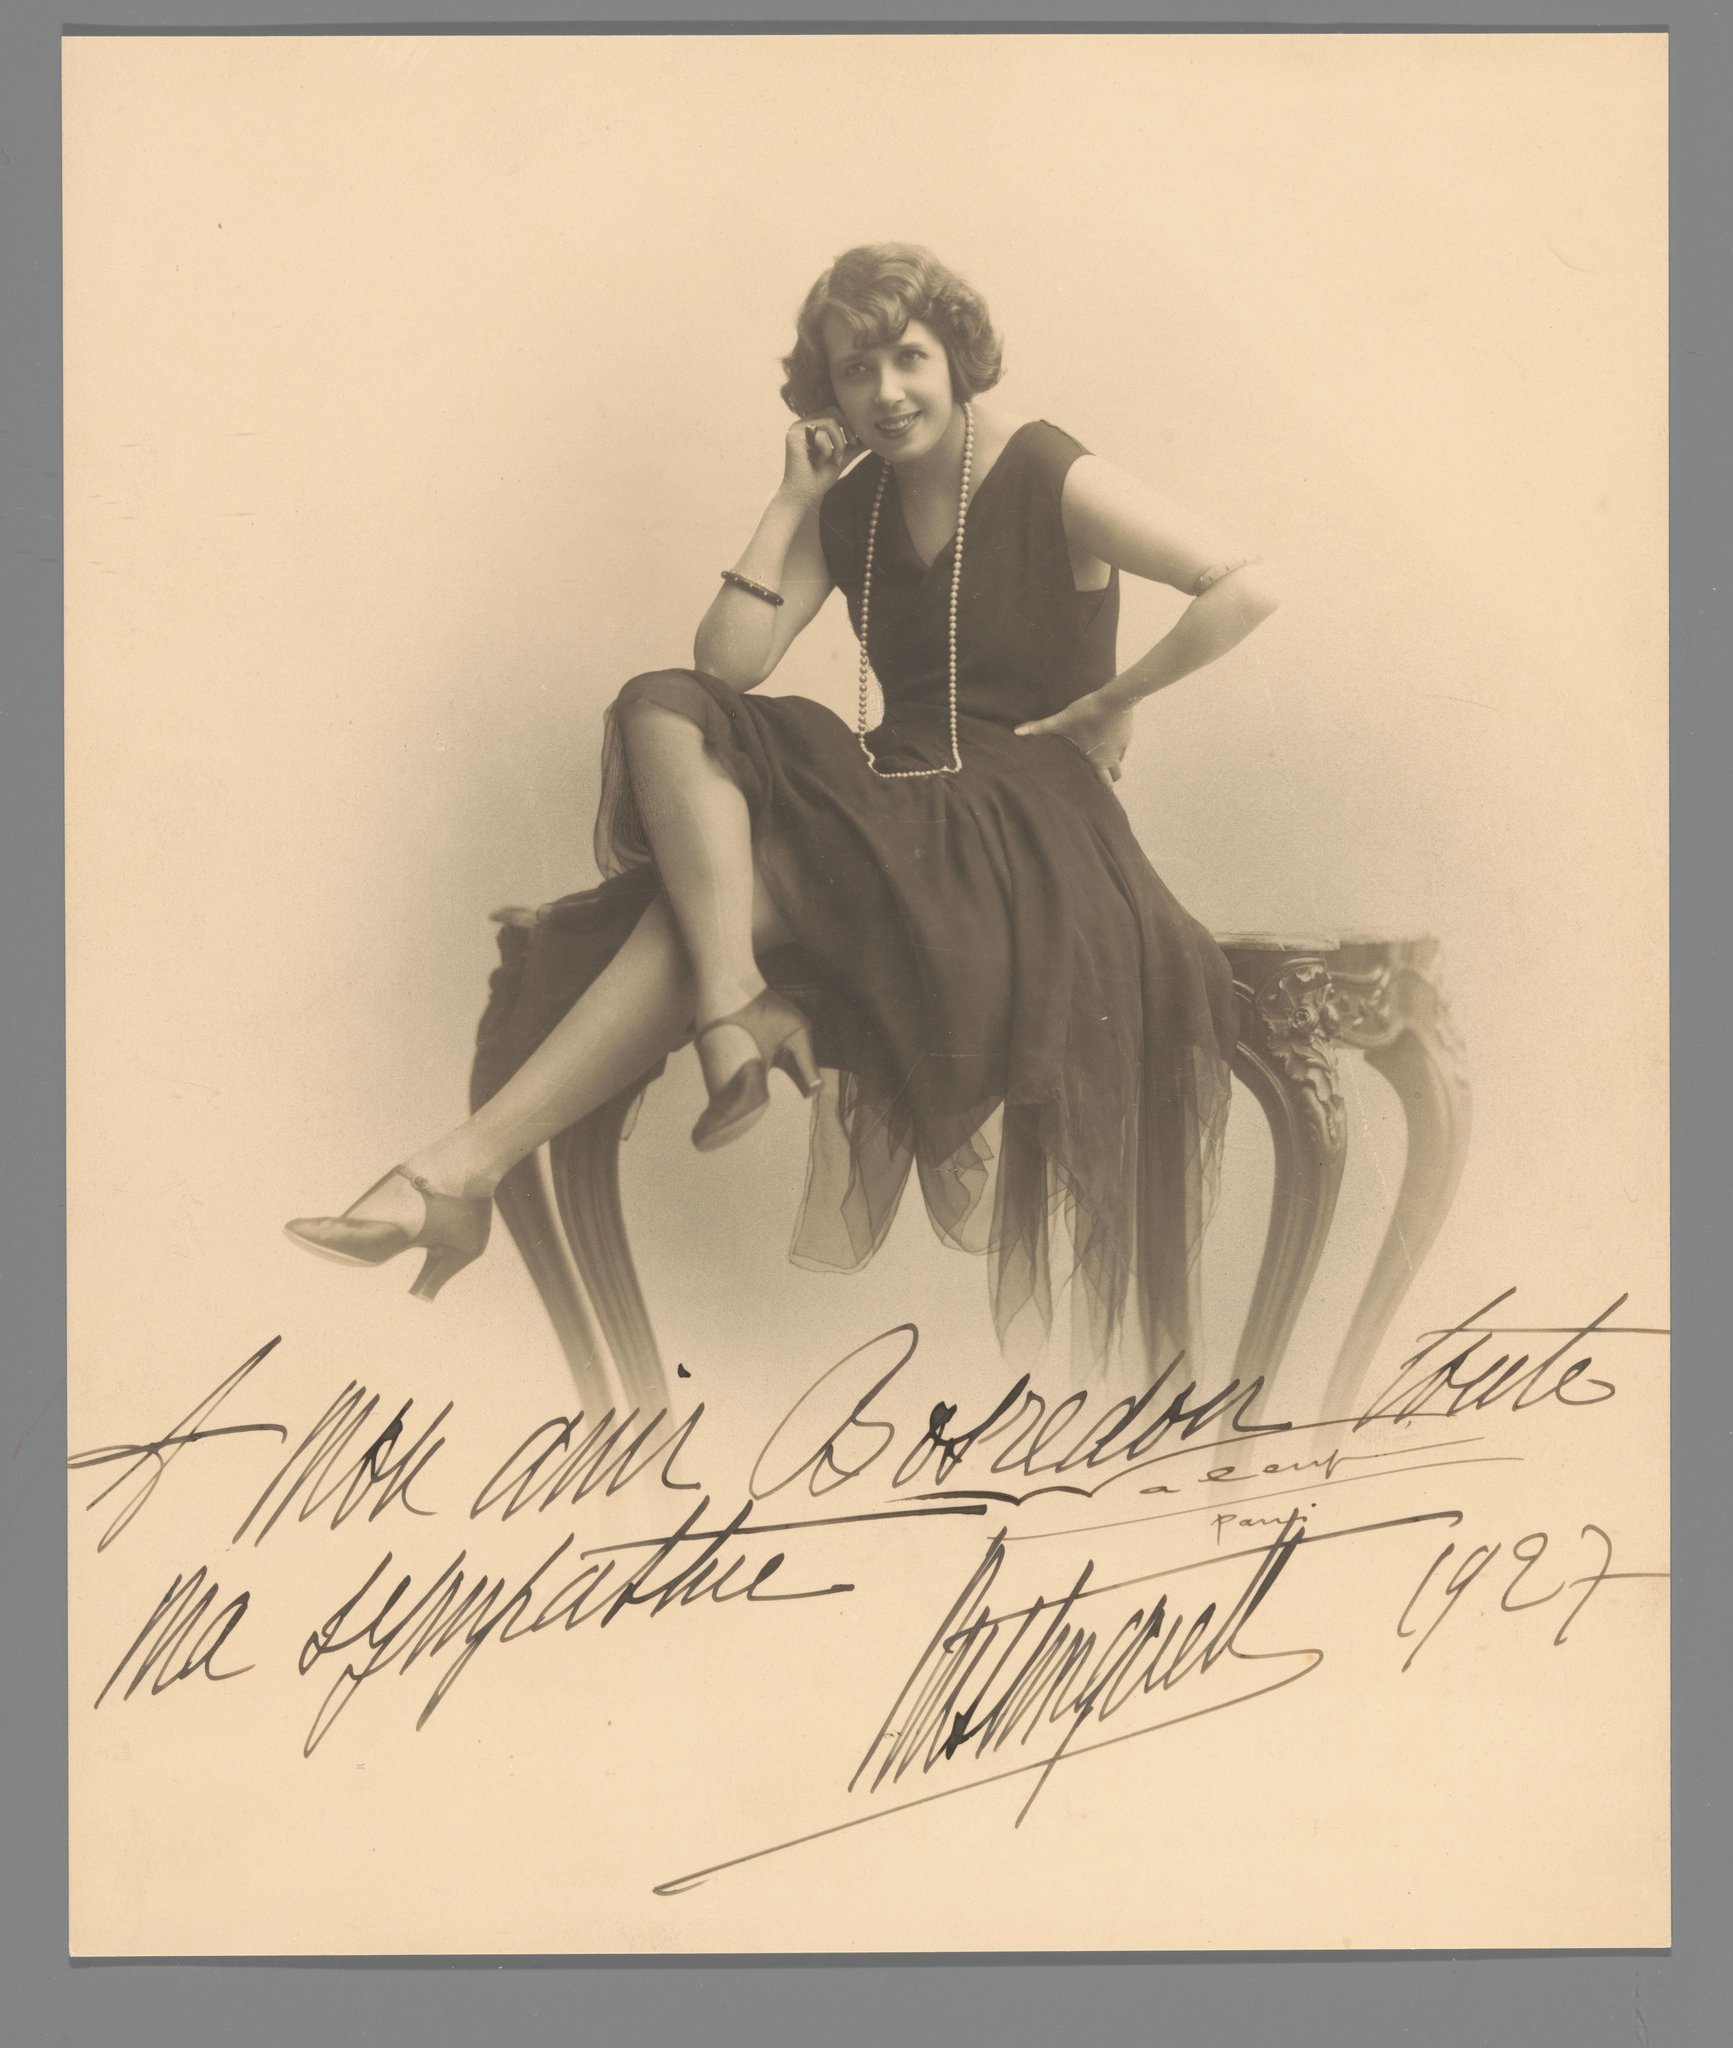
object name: photograph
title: Portret van Mistinguett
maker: walery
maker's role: fotograaf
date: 1920-1927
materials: paper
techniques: gelatin silver print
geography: paris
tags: portrait of actor, actress, paris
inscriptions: inscription